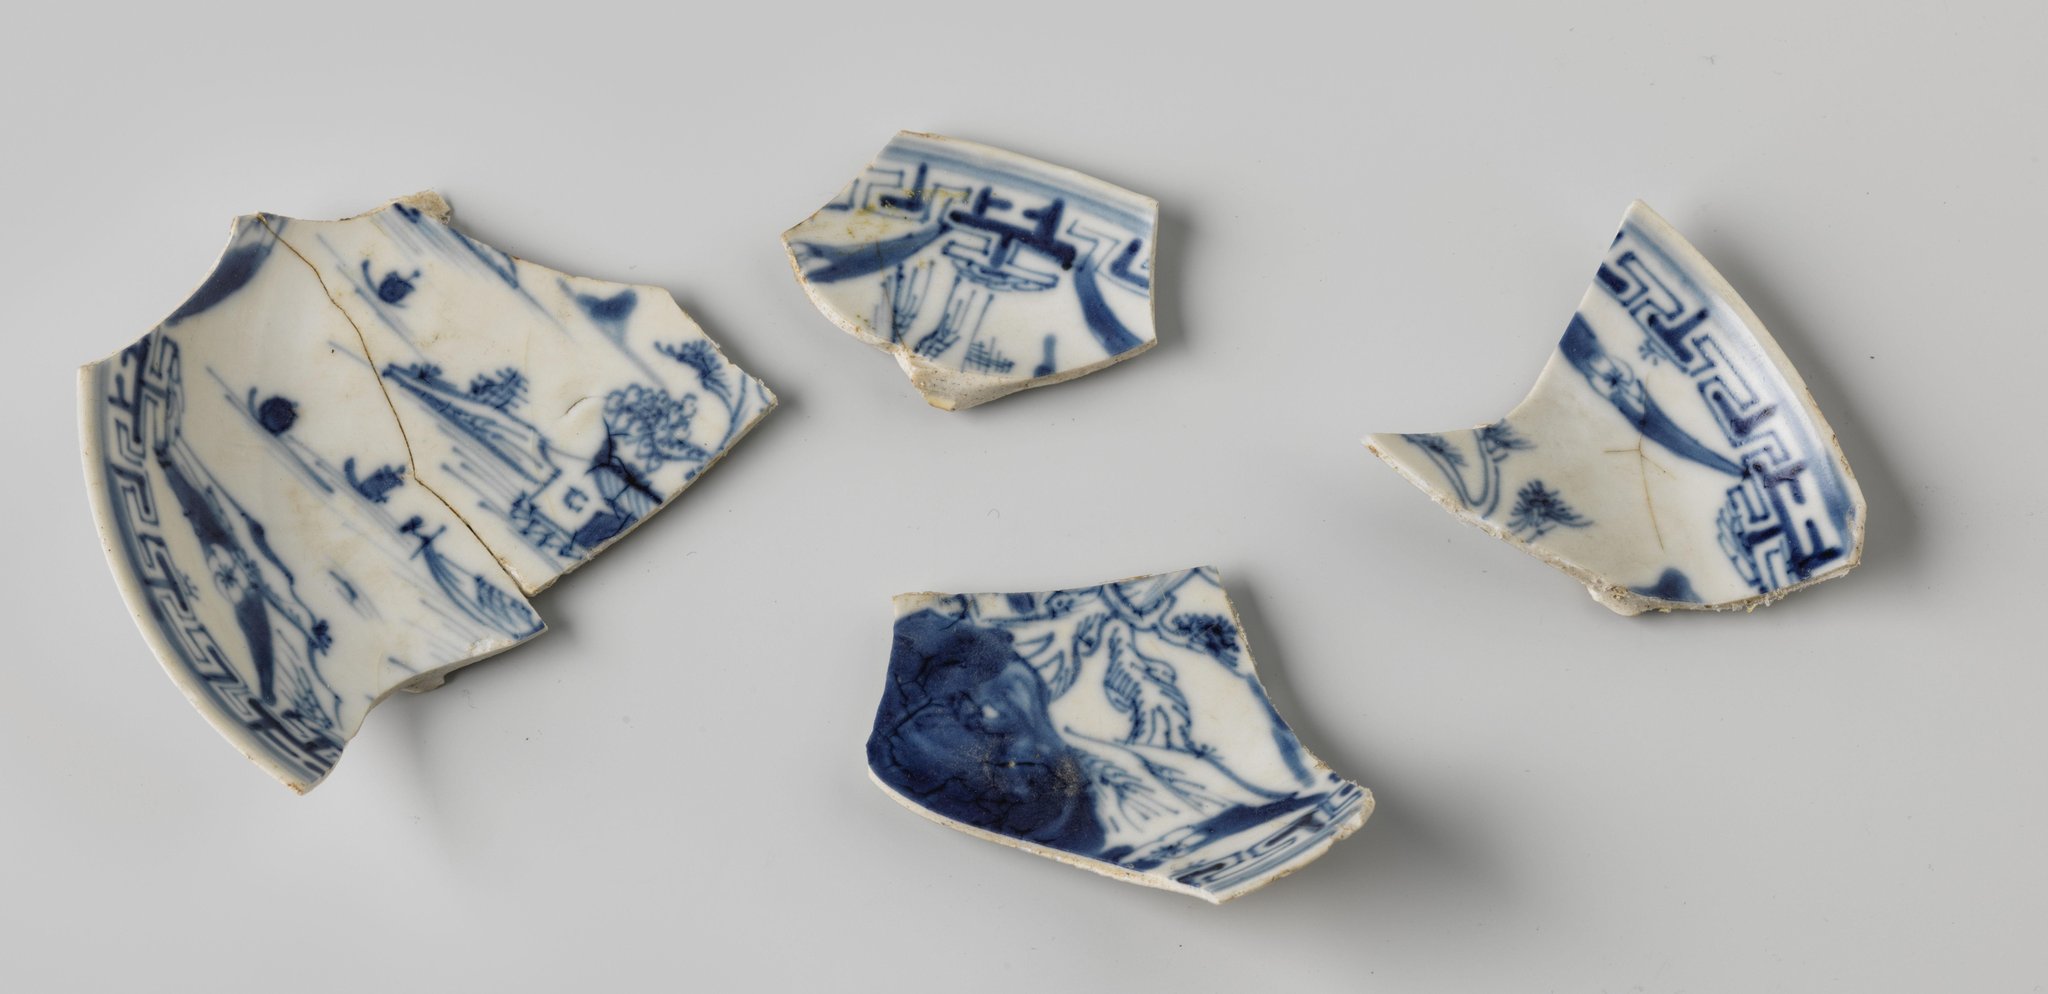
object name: plate dish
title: Bord, gevonden bij V.O.C.-schip Witte Leeuw, mogelijk afkomstig van Zeelelie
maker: Anonymous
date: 1775-1800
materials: porcelain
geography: jingdezhen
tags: verenigde oostindische compagnie, sint-helena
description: Bord bestaande uit vier scherven, waarvan één twee aan elkaar gelijmde fragmenten, gemaakt voor export naar Anglo-Saxische landen, 50% aanwezig. Nanking-ceramiek bord. Dit object is 18e-eeuws en kan dus niet van de vracht van de Witte Leeuw zijn. Onduidelijk is of het object van de site komt of dat het later is vermengd, mogelijk met materiaal van de Zeelelie.